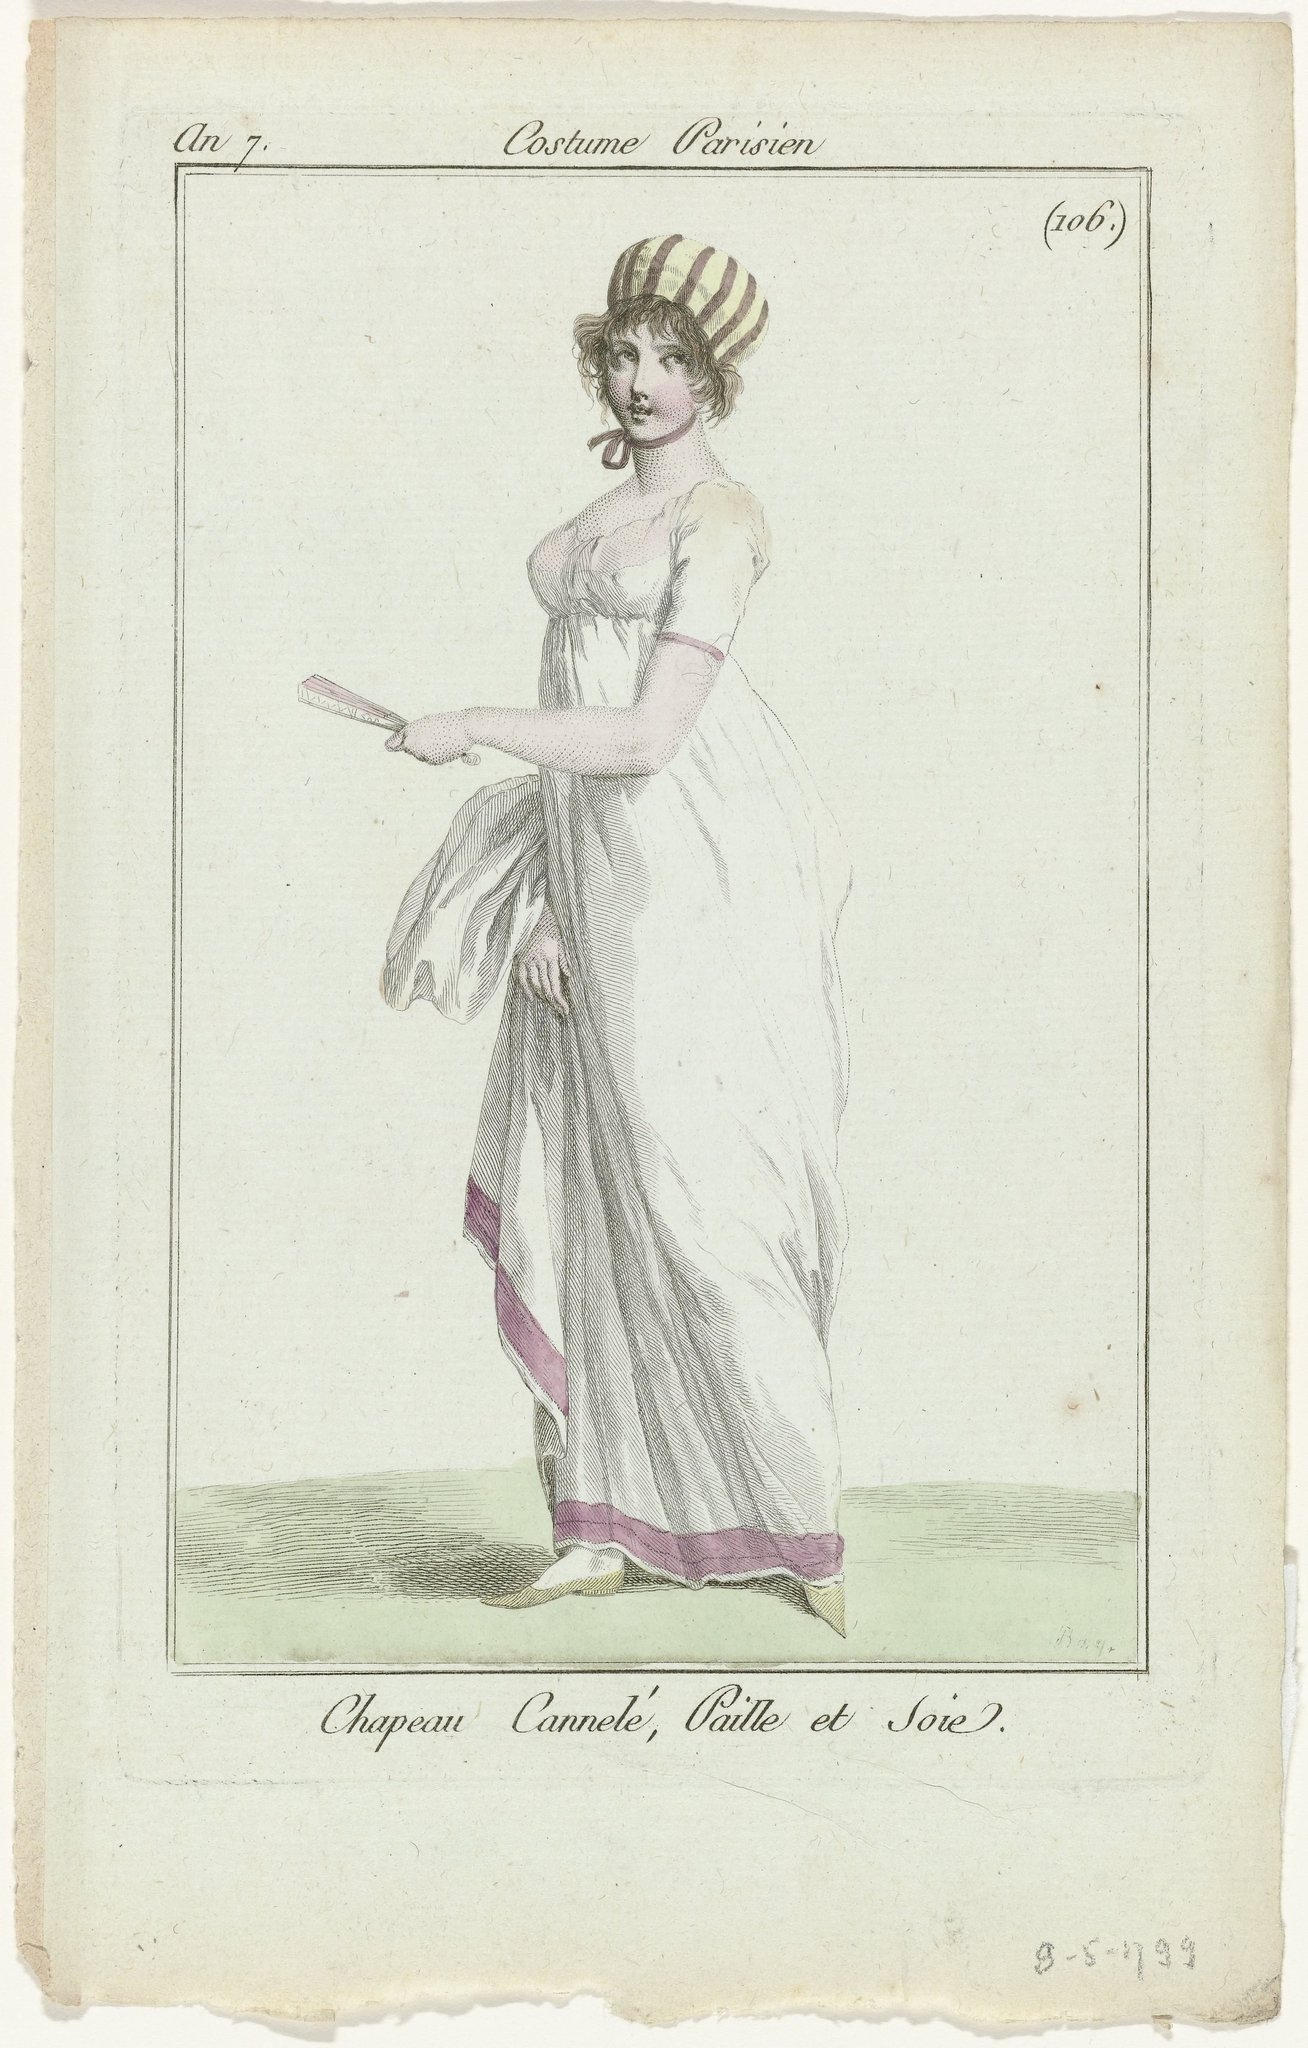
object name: fashion print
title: Journal des Dames et des Modes, Costume Parisien, 9 mai 1799, An 7, (106 (bis)) : Chapeau Cannelé (...)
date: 1799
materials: paper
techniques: engraving, hand coloring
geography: paris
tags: head-gear: hat (+ materials used for clothes), fashion plates, head-gear: hat (+ women's clothes), shoes, sandals (+ women's clothes), dress, gown (+ women's clothes), fan (+ women's clothes)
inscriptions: caption: ‘Chapeau Cannelé, Paille et Soie.’, title: ‘Costume Parisien.’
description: Vrouw met op het hoofd een hoed van stro en zijde: 'Chapeau Cannelé'. Zij draagt een japon met korte mouwen, versierd met roze bies. Met de rechterarm houdt ze haar japon op. In de hand een waaier. platte schoenen met puntige neuzen. De prent maakt deel uit van het modetijdschrift Journal des Dames et des Modes, uitgegeven door Sellèque, Parijs, 1797-1839.